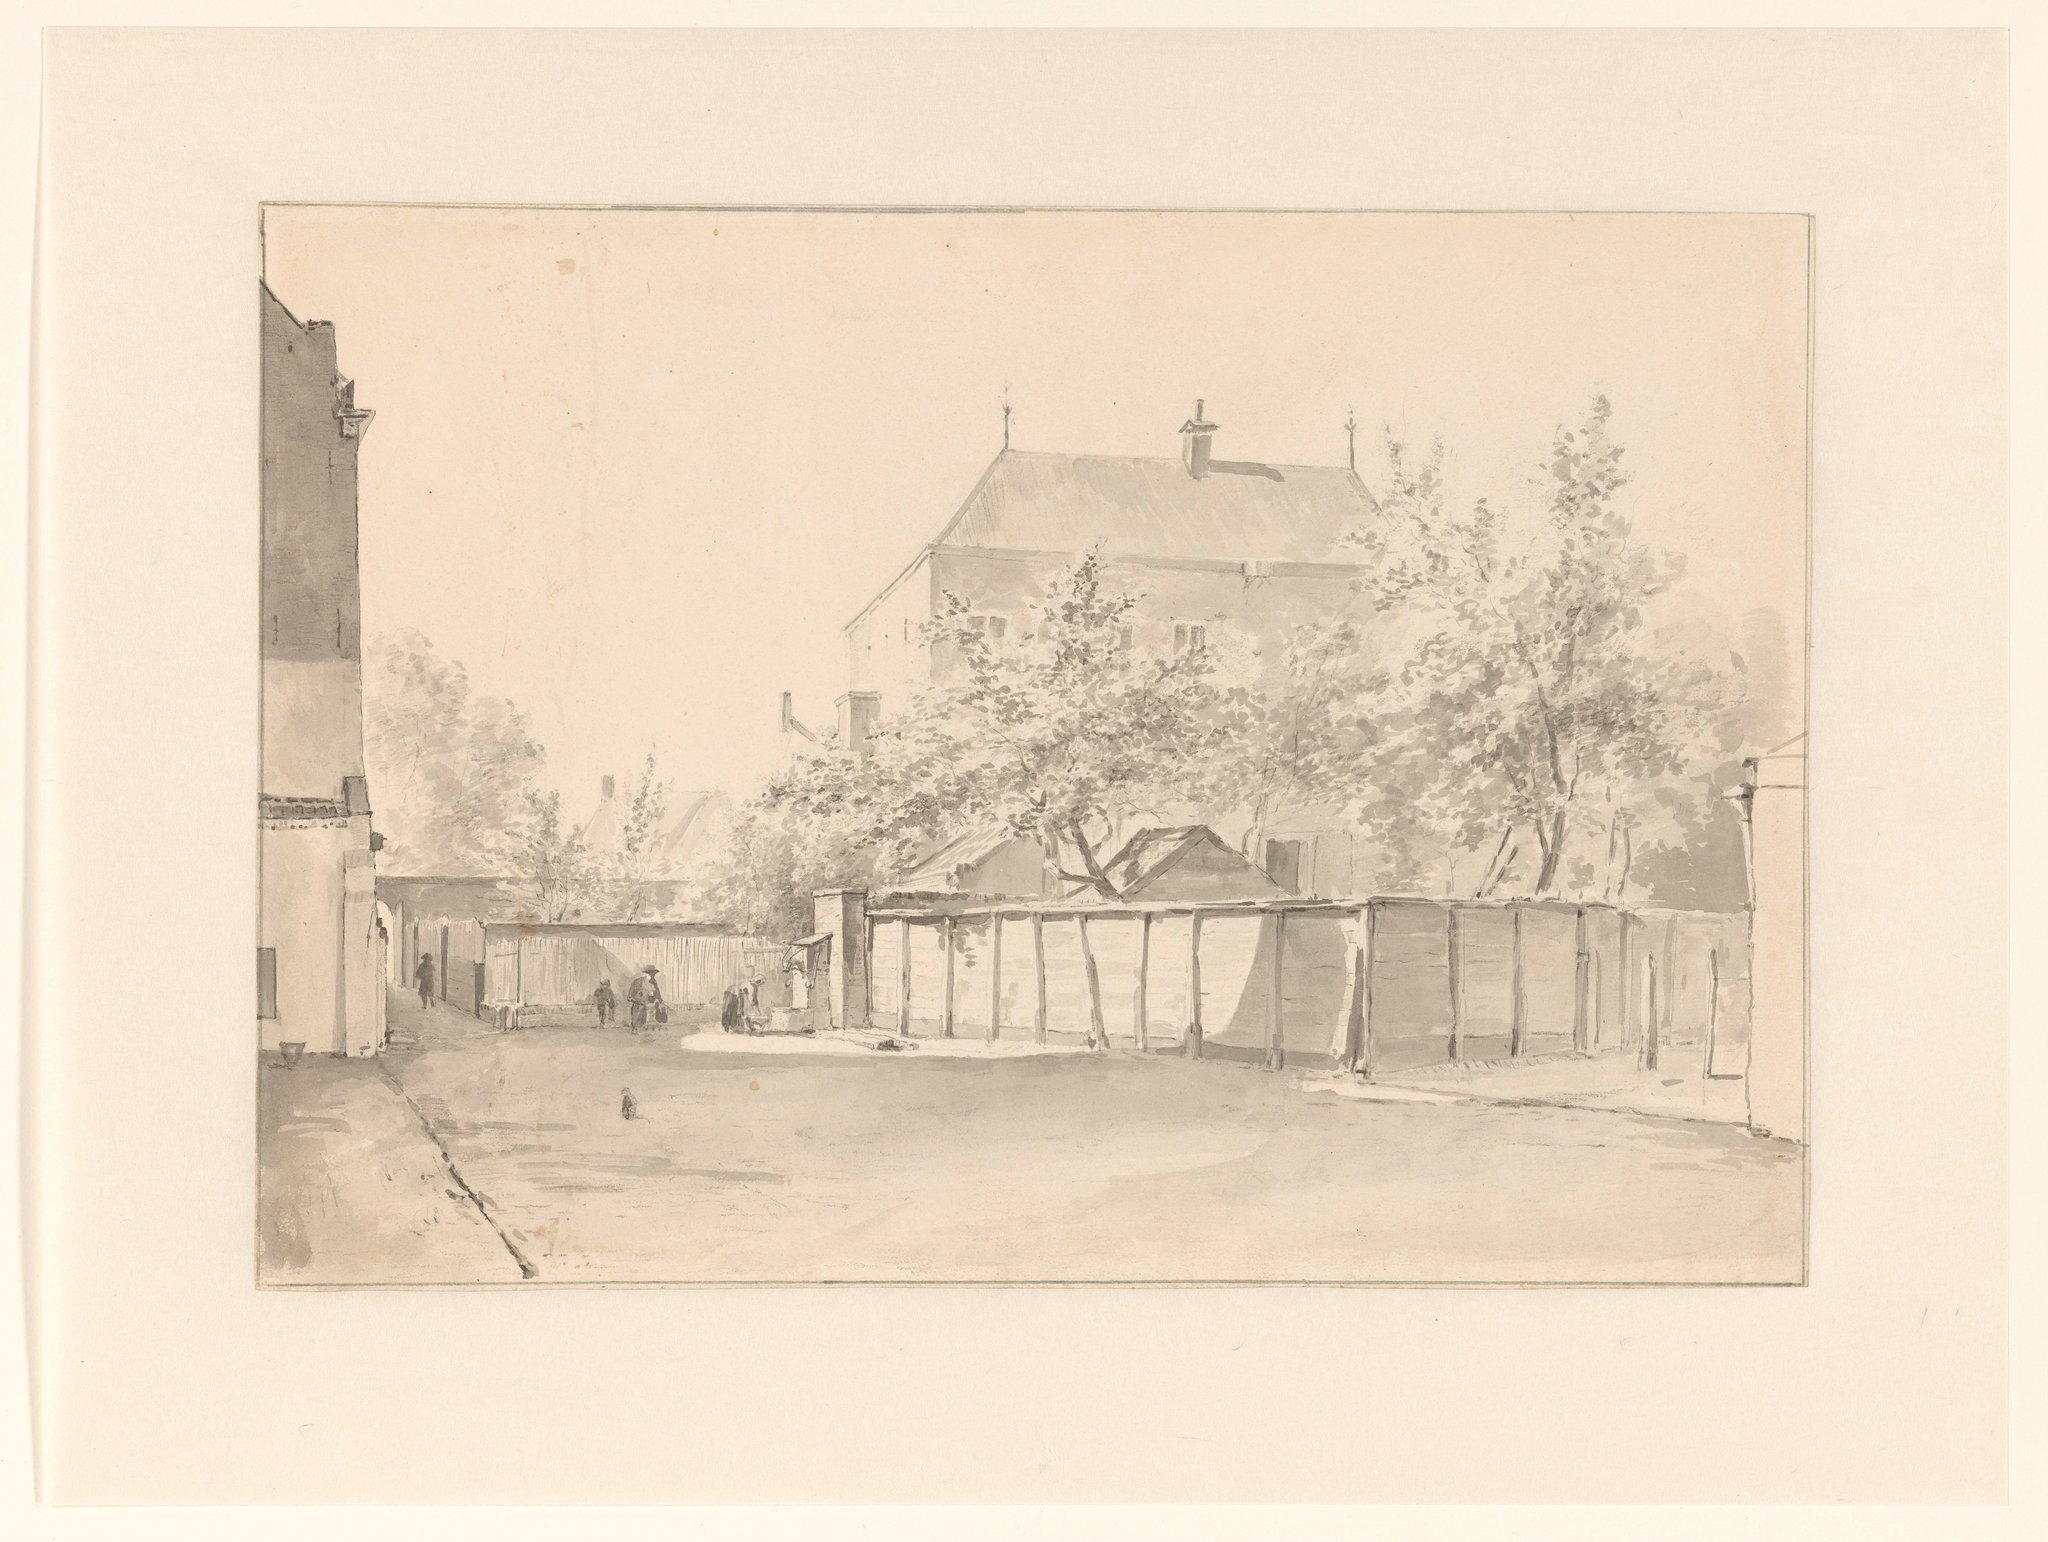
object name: drawing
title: Stadsgezicht met een hoog, door een stenen muur omgeven huis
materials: paper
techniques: brush